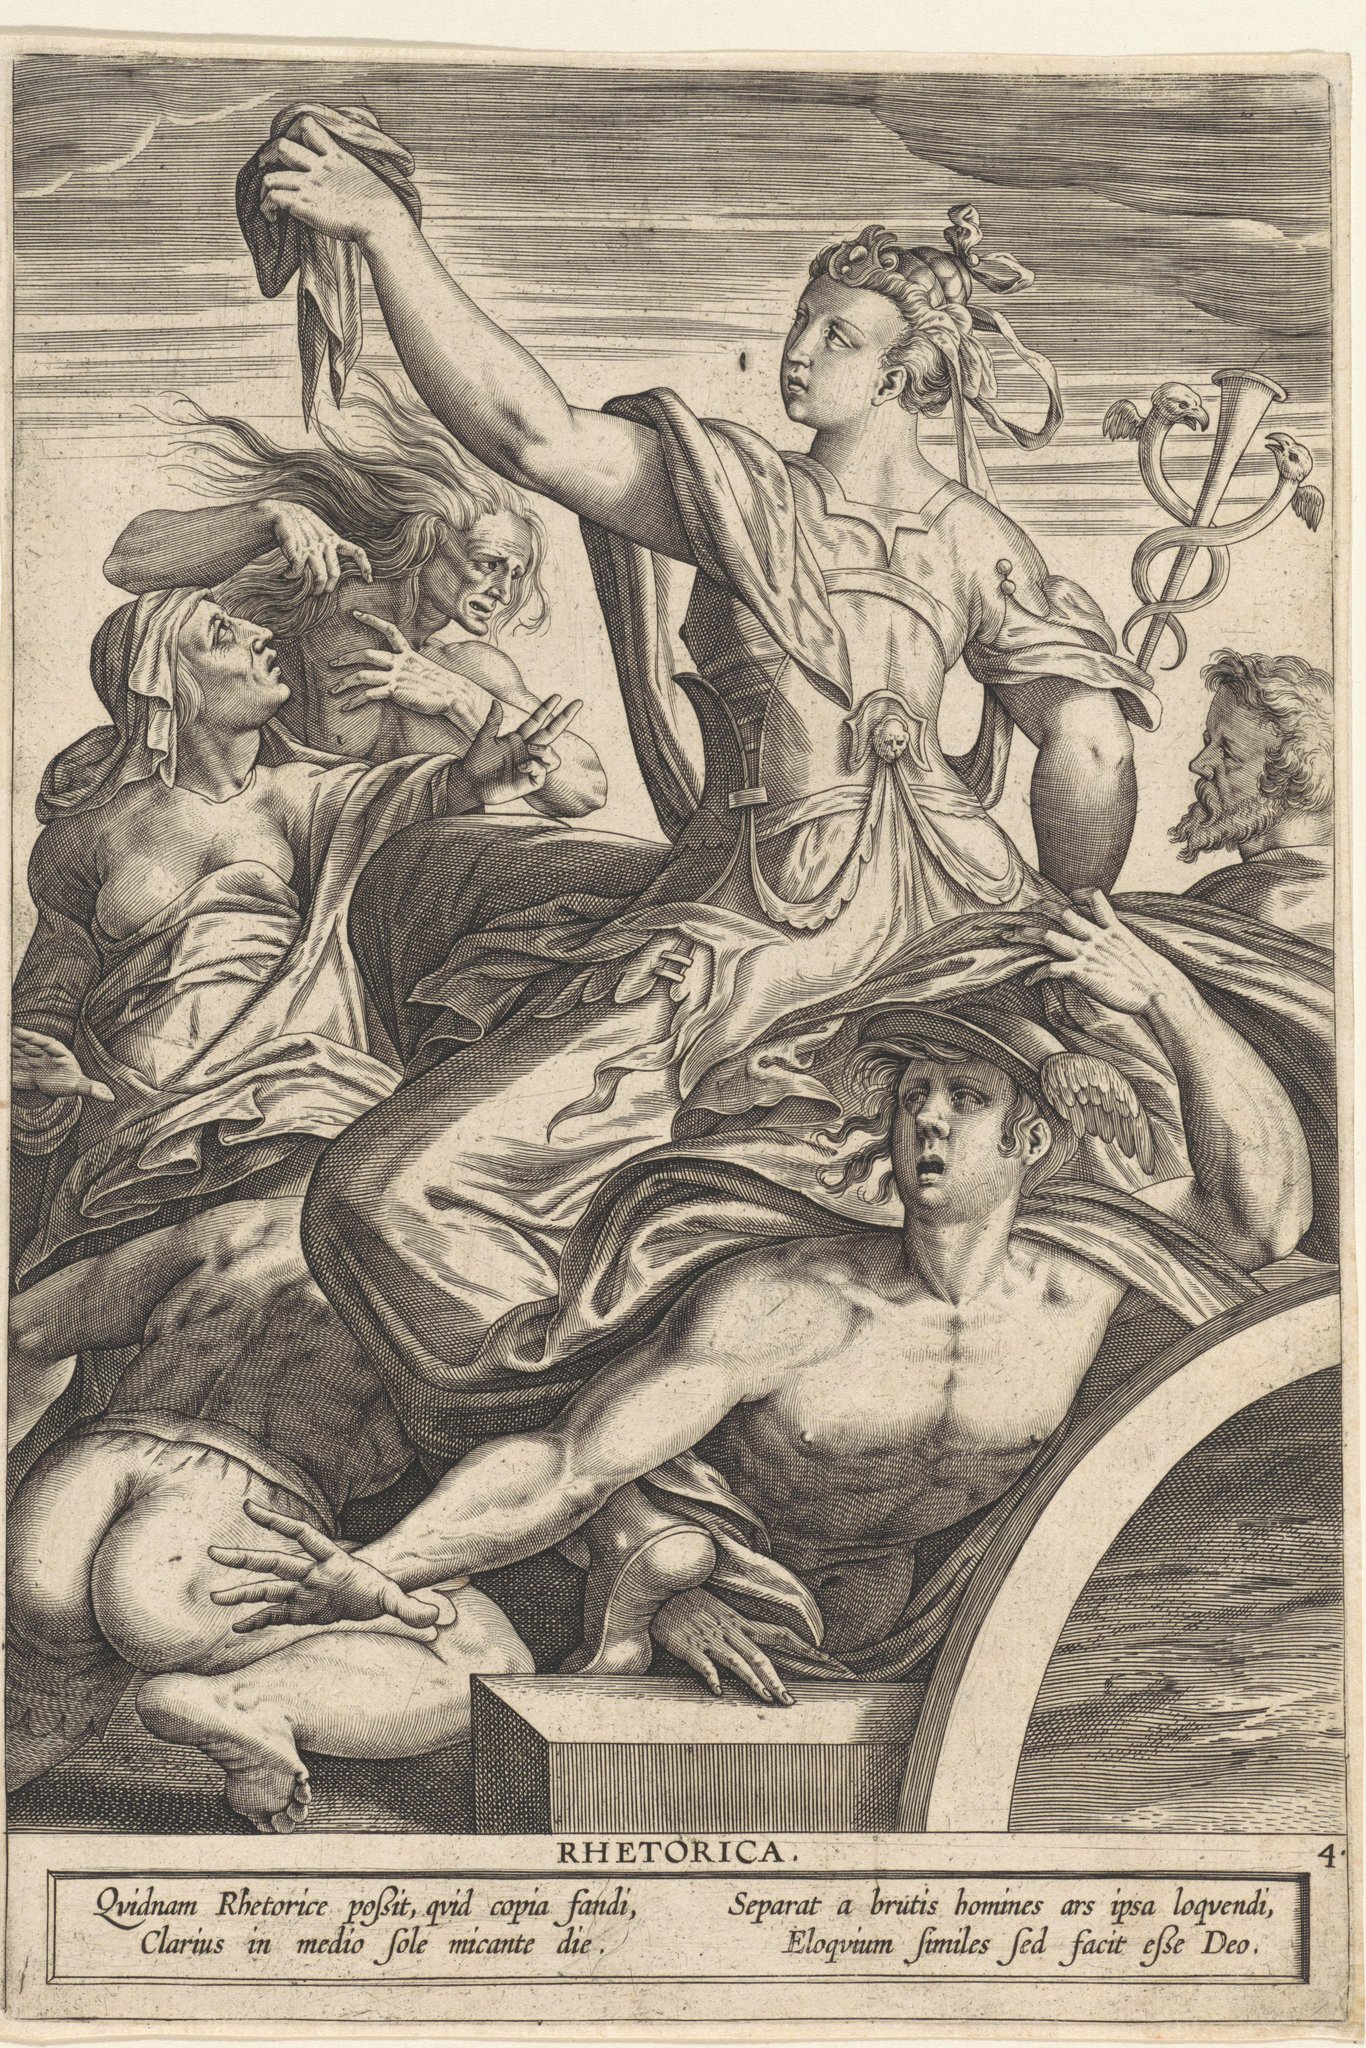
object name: print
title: De Zeven Vrije Kunsten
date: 1592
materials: paper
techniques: engraving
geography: antwerp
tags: 'rhetorica', 'eloquentia' (~ trivium); 'rettorica' (ripa)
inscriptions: collector's mark: Lugt 2228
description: De vrouwelijke personificatie van Retorica, in haar handen een doek en de caduceus. Ze is omringd door verschrikte mannen en vrouwen. In het kader in de marge een vierregelig onderschrift, in twee kolommen, in het Latijn.